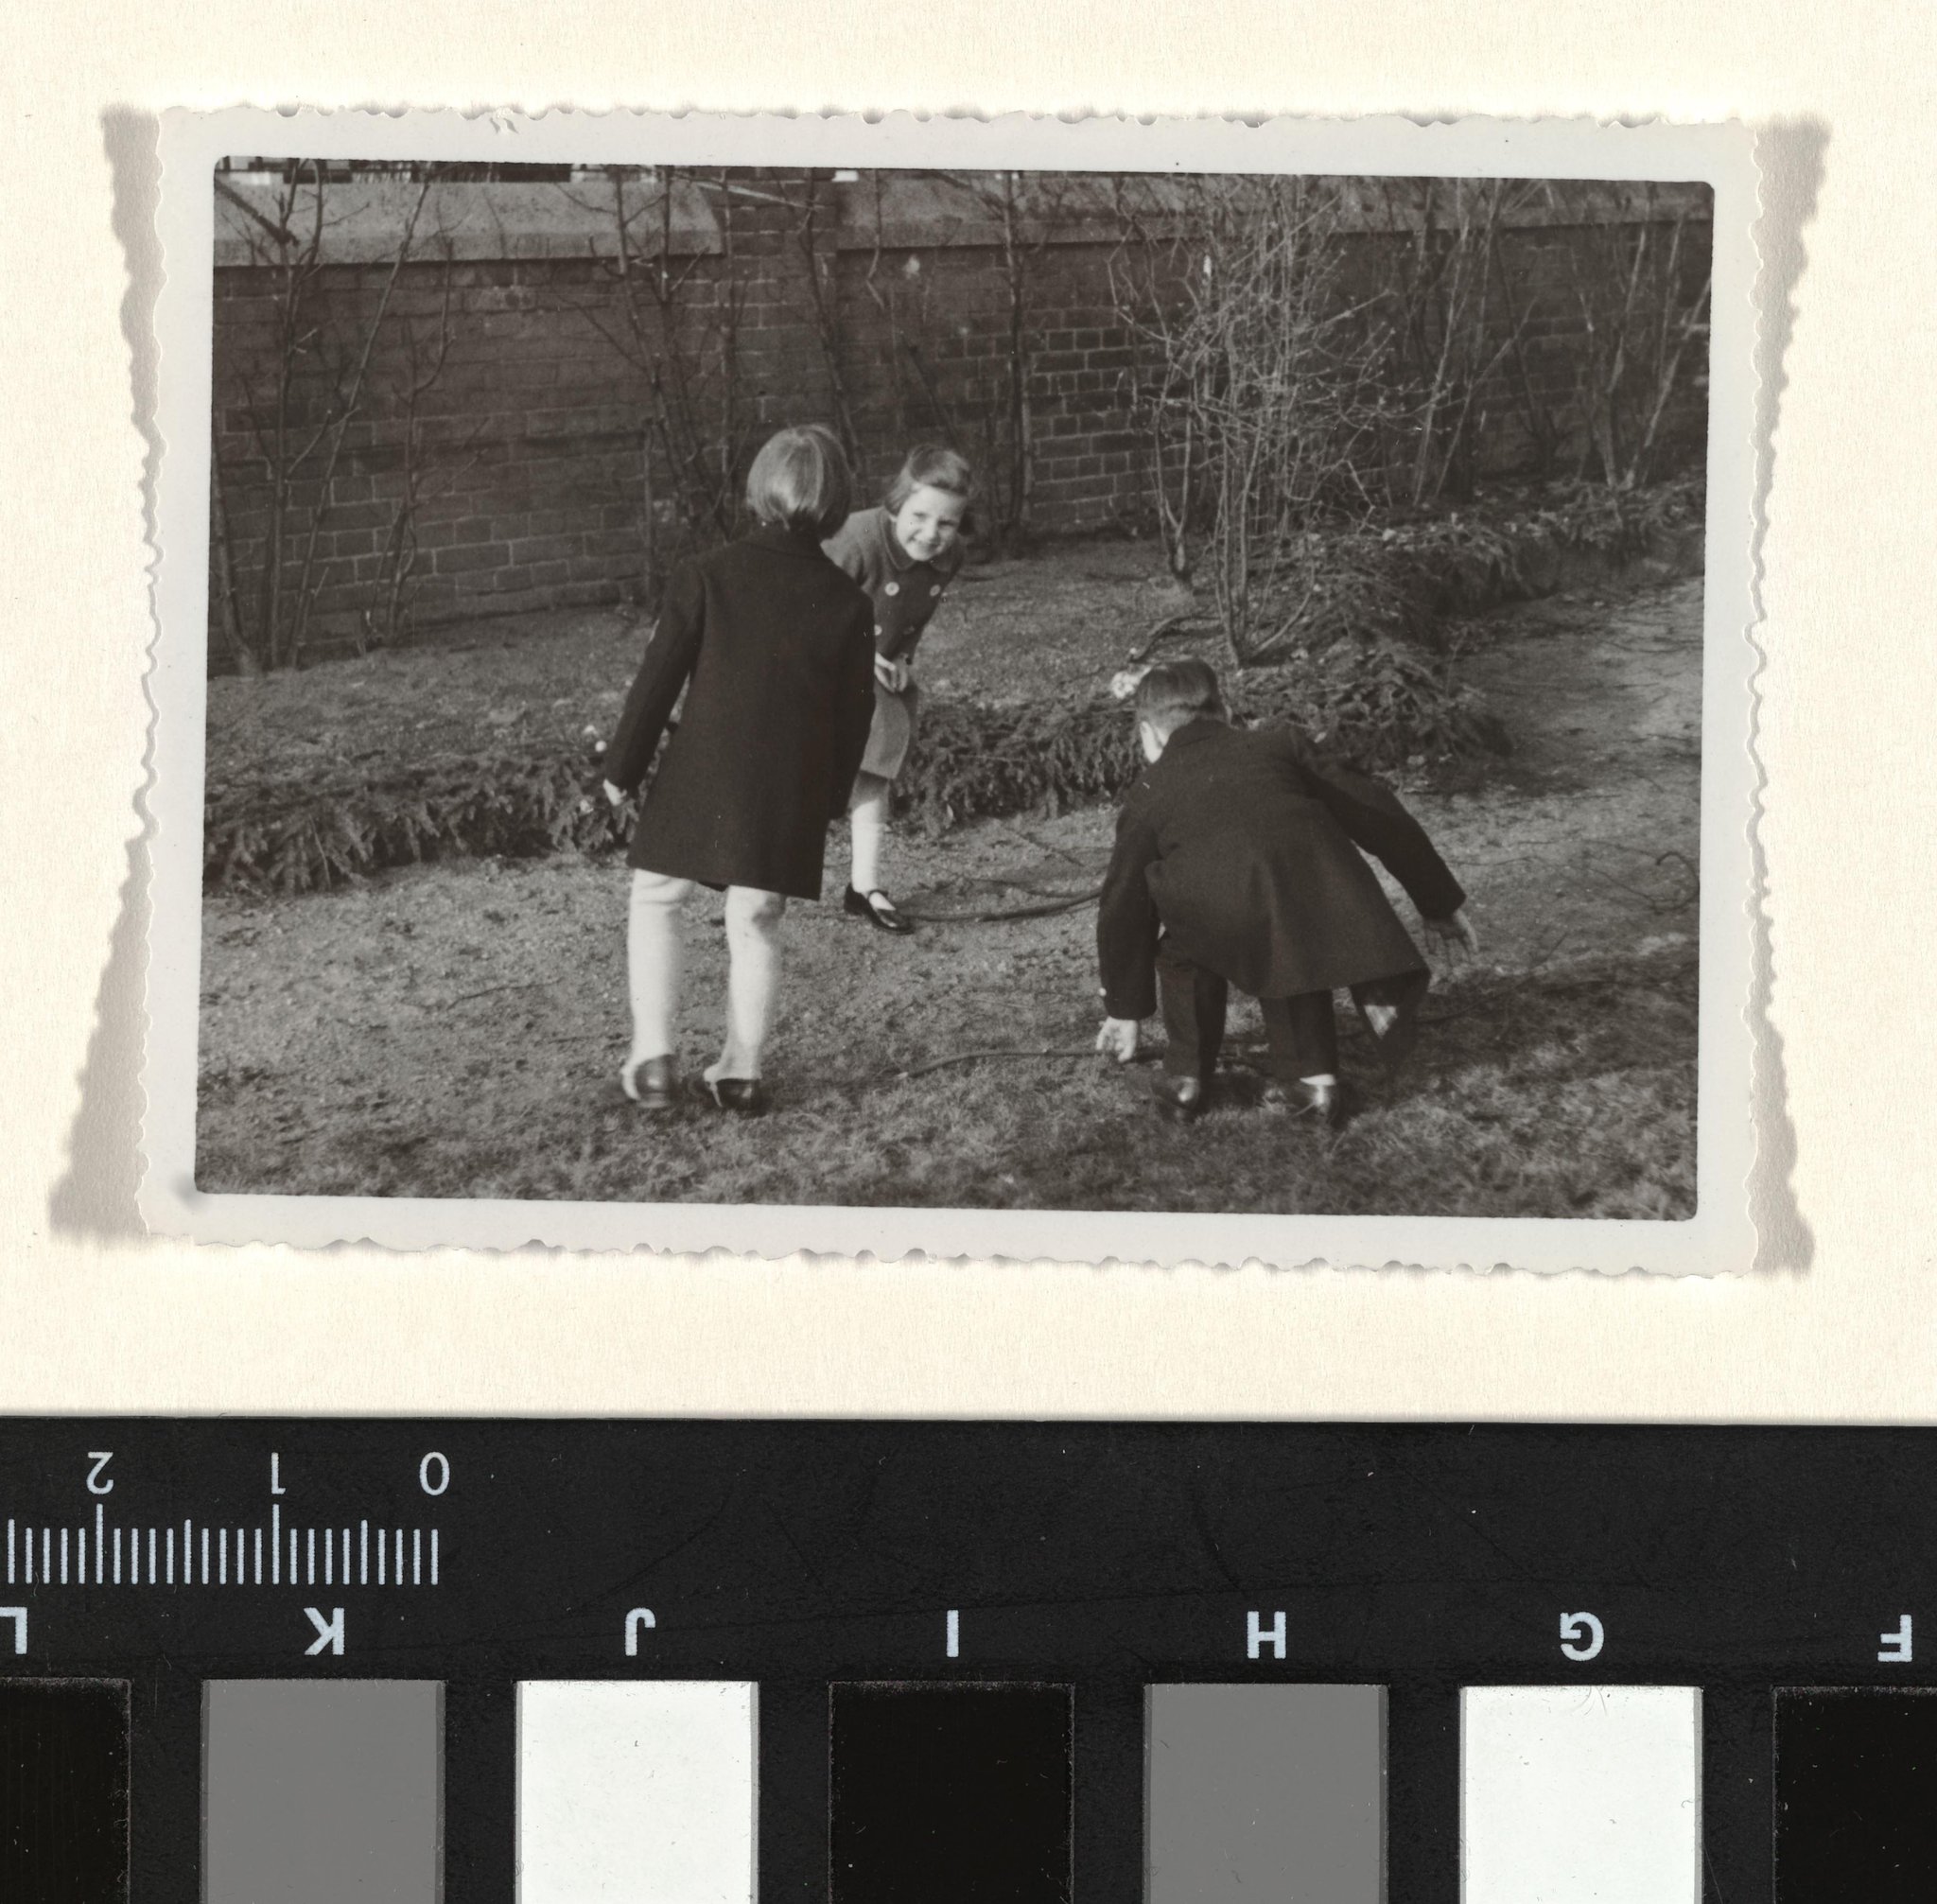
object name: photograph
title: Isabel Wachenheimer, Erica en Hansl in de tuin van de woning van Willy Moos in Hamburg, Bellevue 62, in maart-april 1935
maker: Anonymous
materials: photographic support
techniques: gelatin silver print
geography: hamburg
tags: leiden, isabel wachenheimer-elon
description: Dit object is onderdeel van de nalatenschap van Isabel Elon-Wachenheimer (1928-2010). Tot haar overlijden behoorde het samen met de andere objecten uit de nalatenschap tot haar privédomein van Isabel Wachenheimer. In die particuliere context zijn deze objecten tezamen en individueel aandenkens - aan de jeugd, ouders en familie van Isabel Wachenheimer vóór en tijdens de Shoah en aan haar leven na de Tweede Wereldoorlog. Isabel Wachenheimer, die van juni 1943 tot mei 1945 gevangen zat in Kamp Westerbork, Theresienstadt, Auschwitz, Lenzing a/d Oberdonau (een buitenkamp van Mauthausen), overleefde de Shoah. Haar ouders – Eugène Wachenheimer en Else Wachenheimer-Moos - werden op 14 oktober 1944 in Auschwitz-Birkenau vermoord.